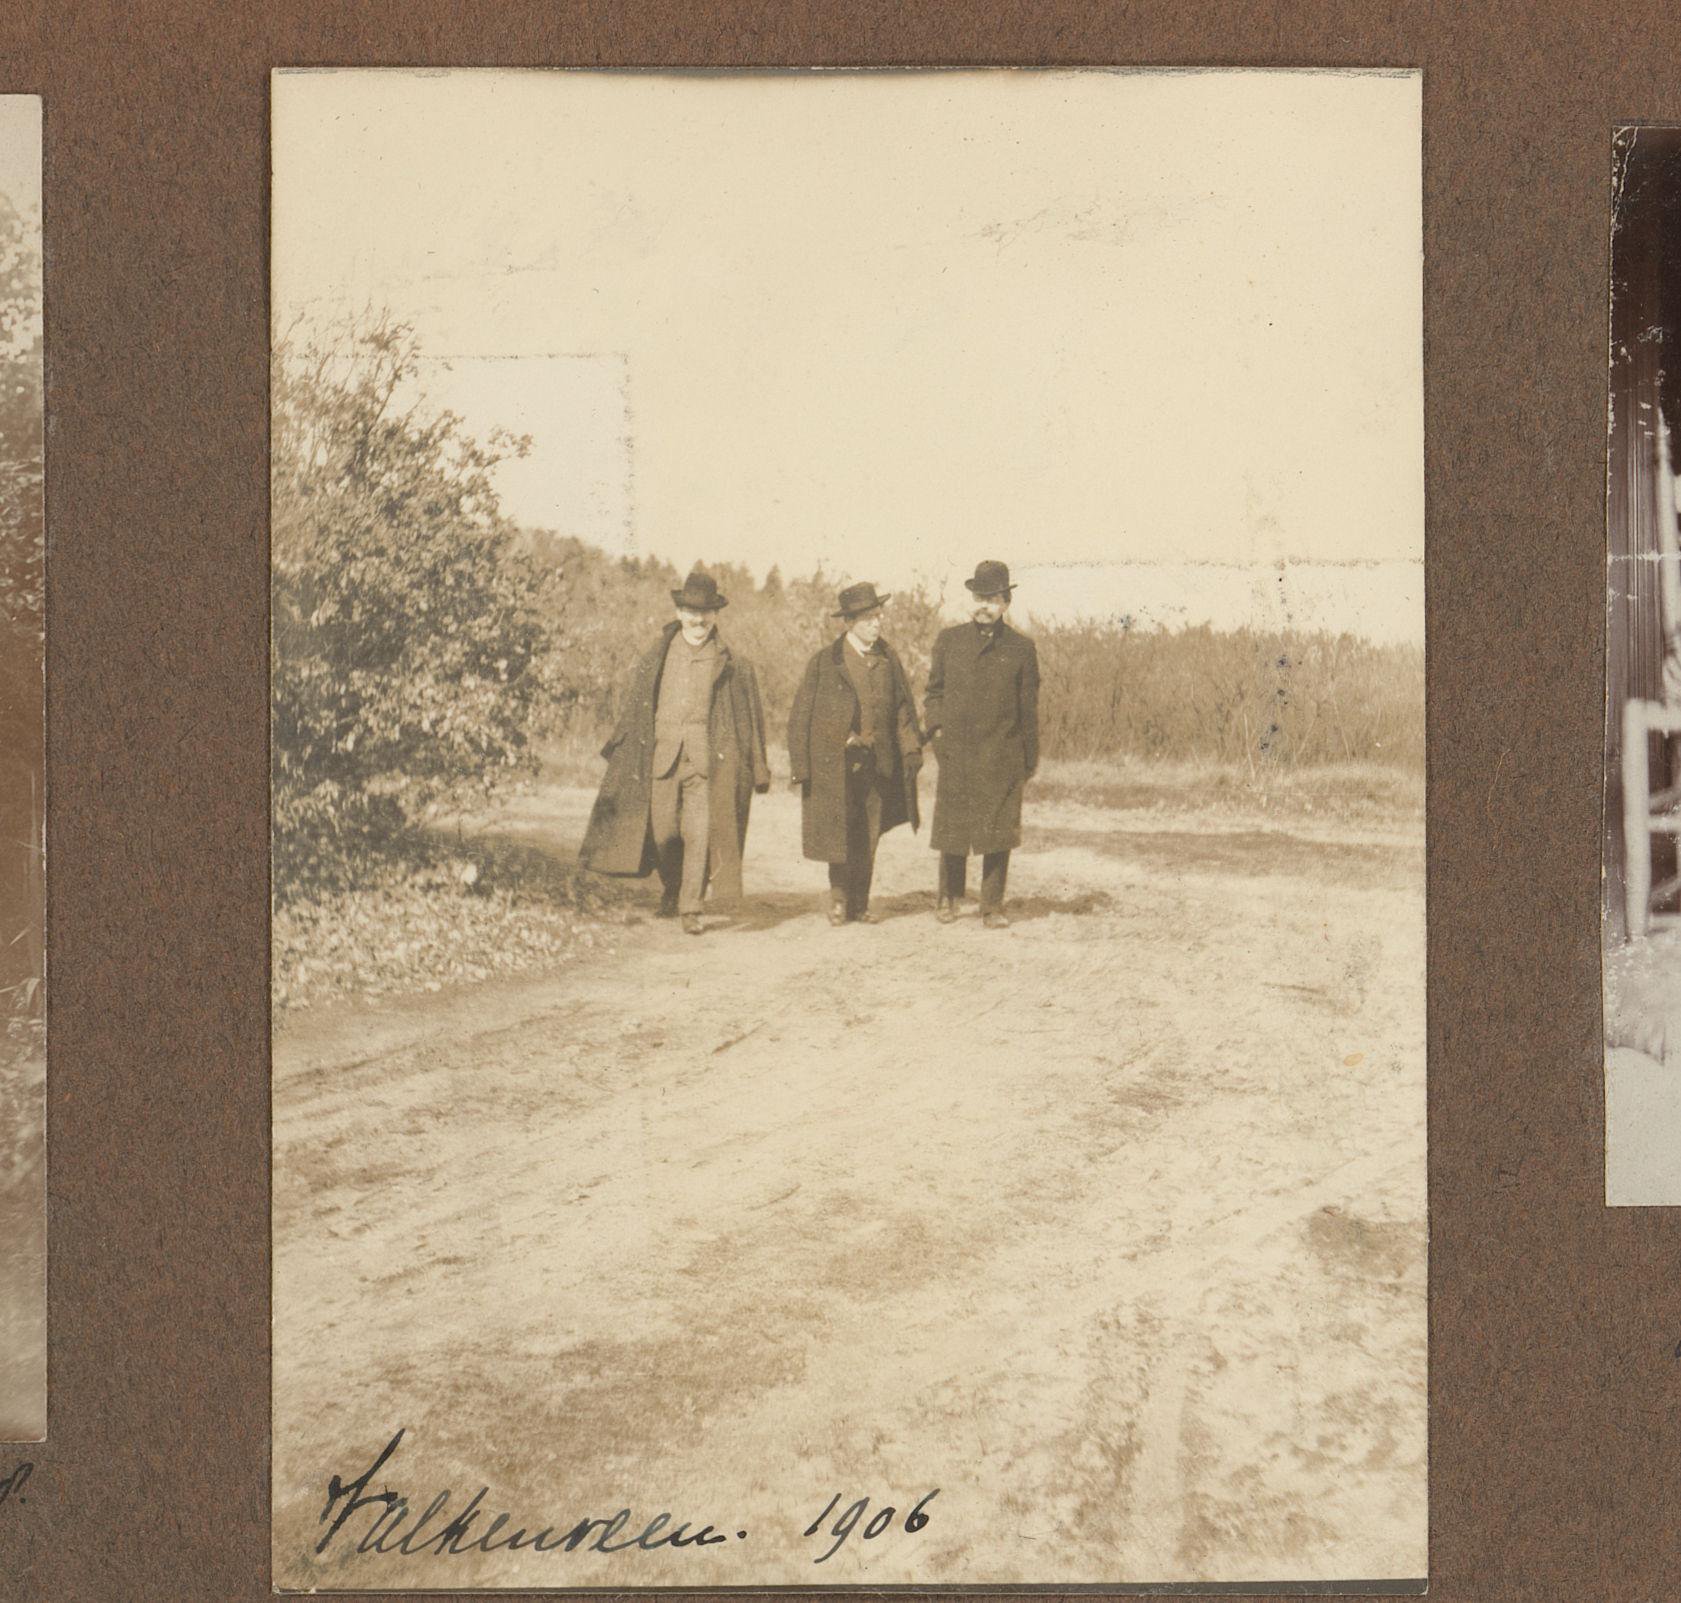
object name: photograph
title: Drie wandelende mannen: links Willem Mengelberg, midden Gustav Mahler, rechts Alphons Diepenbrock, Valkenerveen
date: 1906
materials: photographic support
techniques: gelatin silver print, pasting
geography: amsterdam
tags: utrecht, amsterdam, alphons diepenbrock, vienna, gustav mahler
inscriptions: date: ‘1912.’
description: Foto op bruin albumblad 11 van familiealbum van Alphons Diepenbrock.